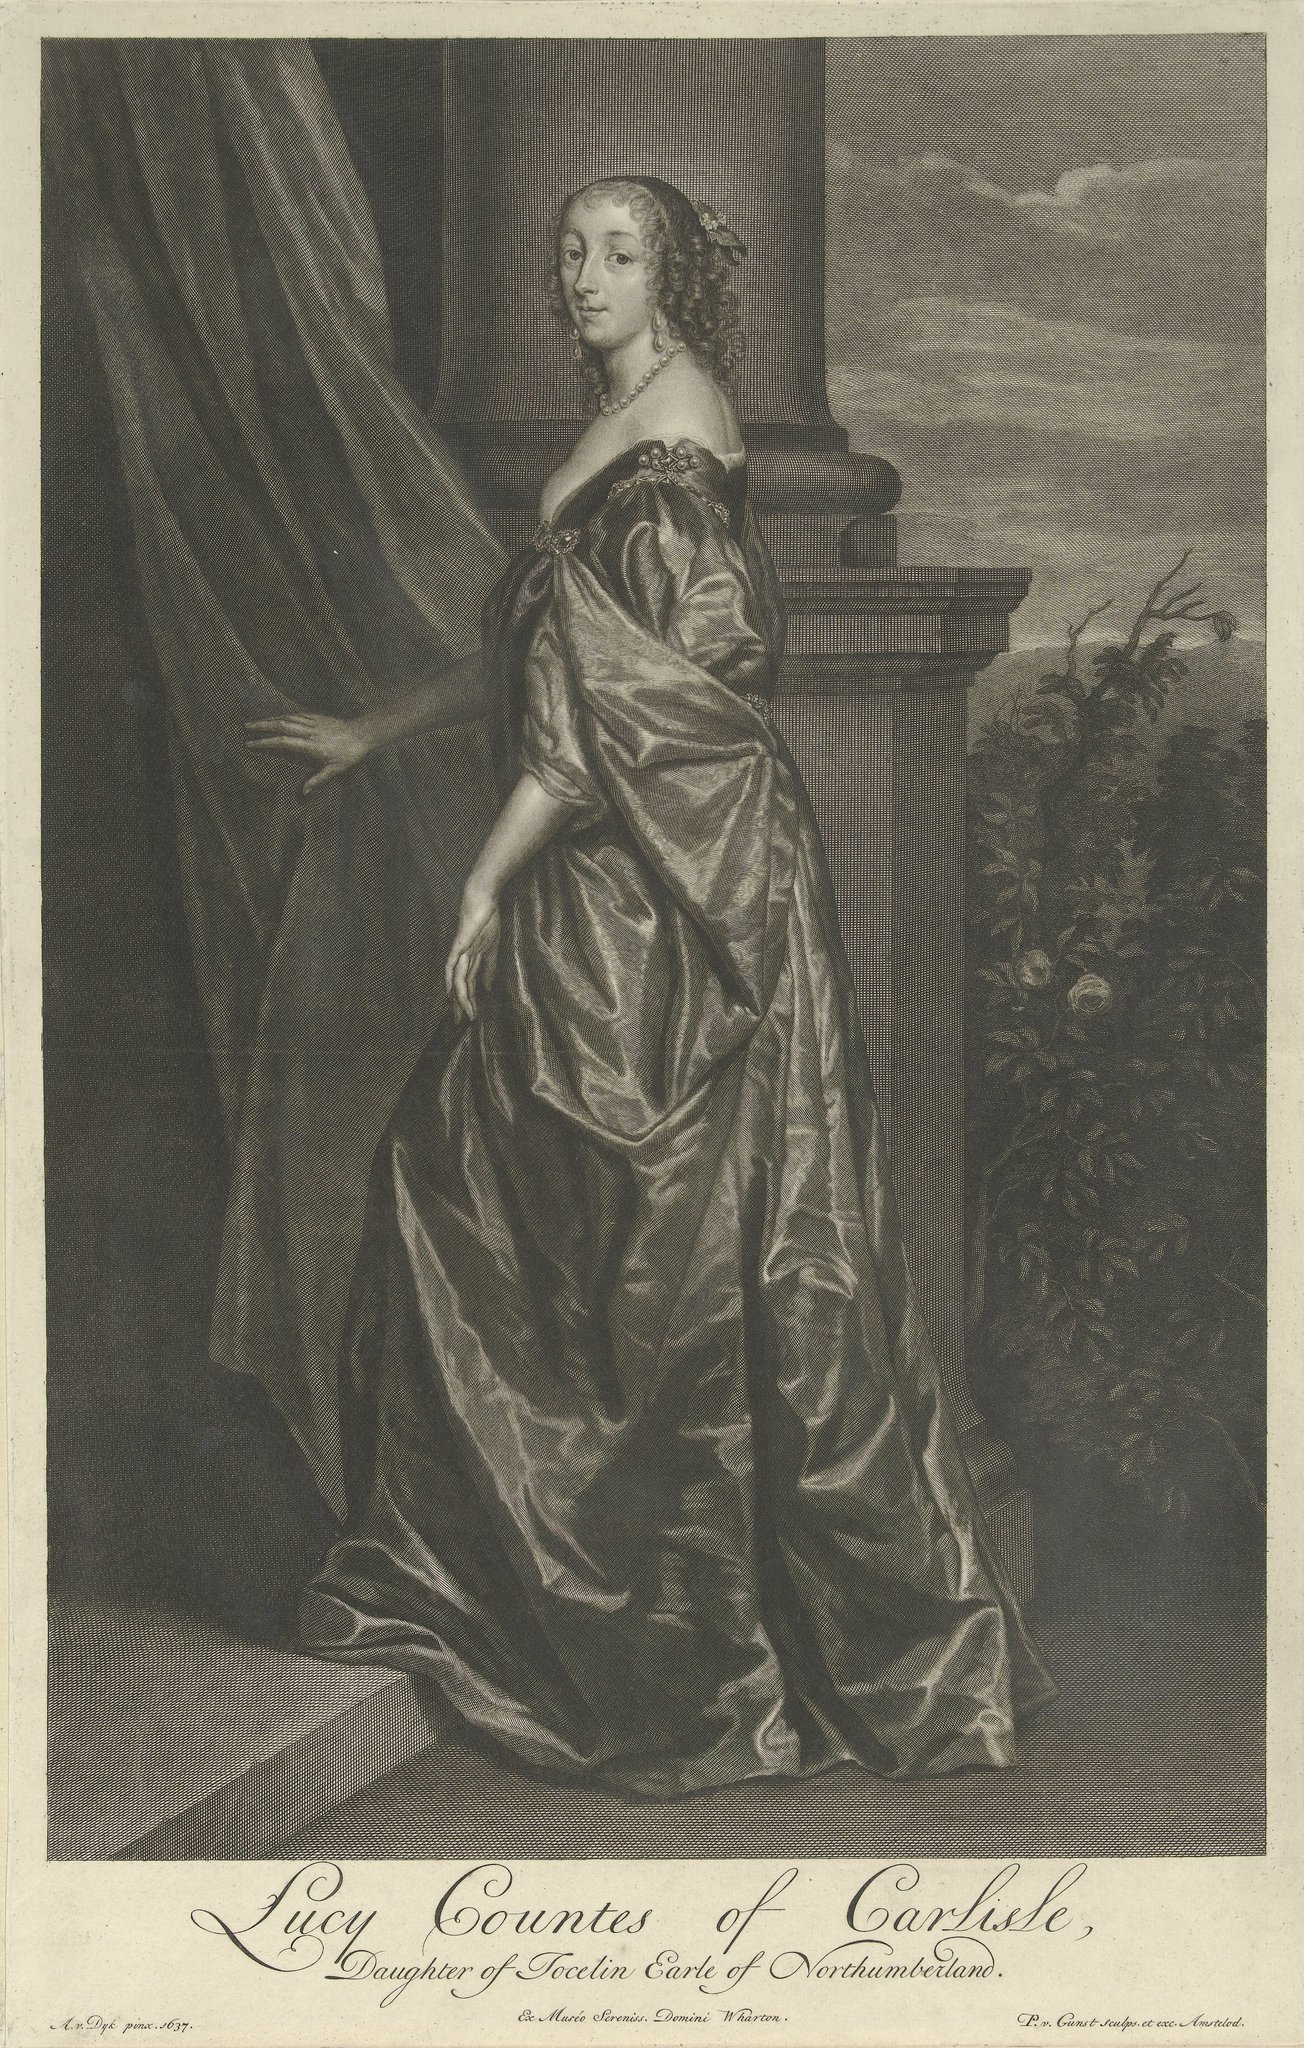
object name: book illustration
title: Portret van Lucy Hay, hertogin van Carlisle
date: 1716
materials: paper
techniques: engraving, etching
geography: amsterdam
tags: lucy hay (hertogin van carlisle)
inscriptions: collector's mark: Lugt 240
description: Boekillustratie voor Gunst, Pieter van. Decem Magna Arte Et Summa Dexteritate Pictas Effigies. Amsterdam, voor Pieter van Gunst, 1716.